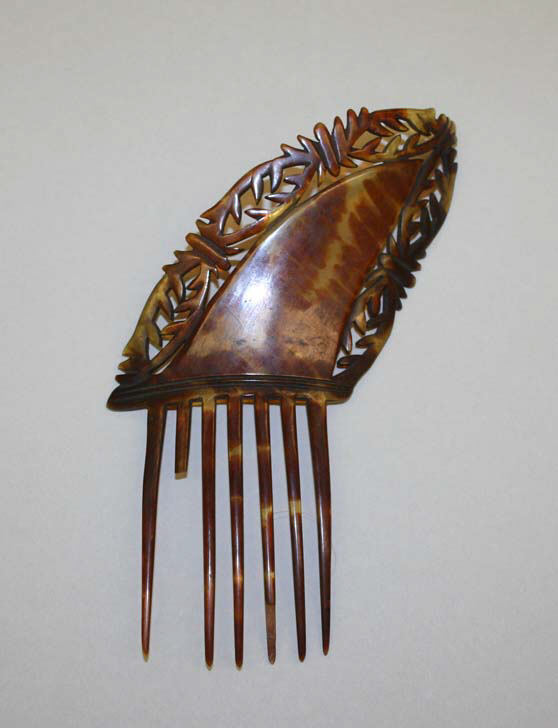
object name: comb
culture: european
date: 1830-1839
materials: shell